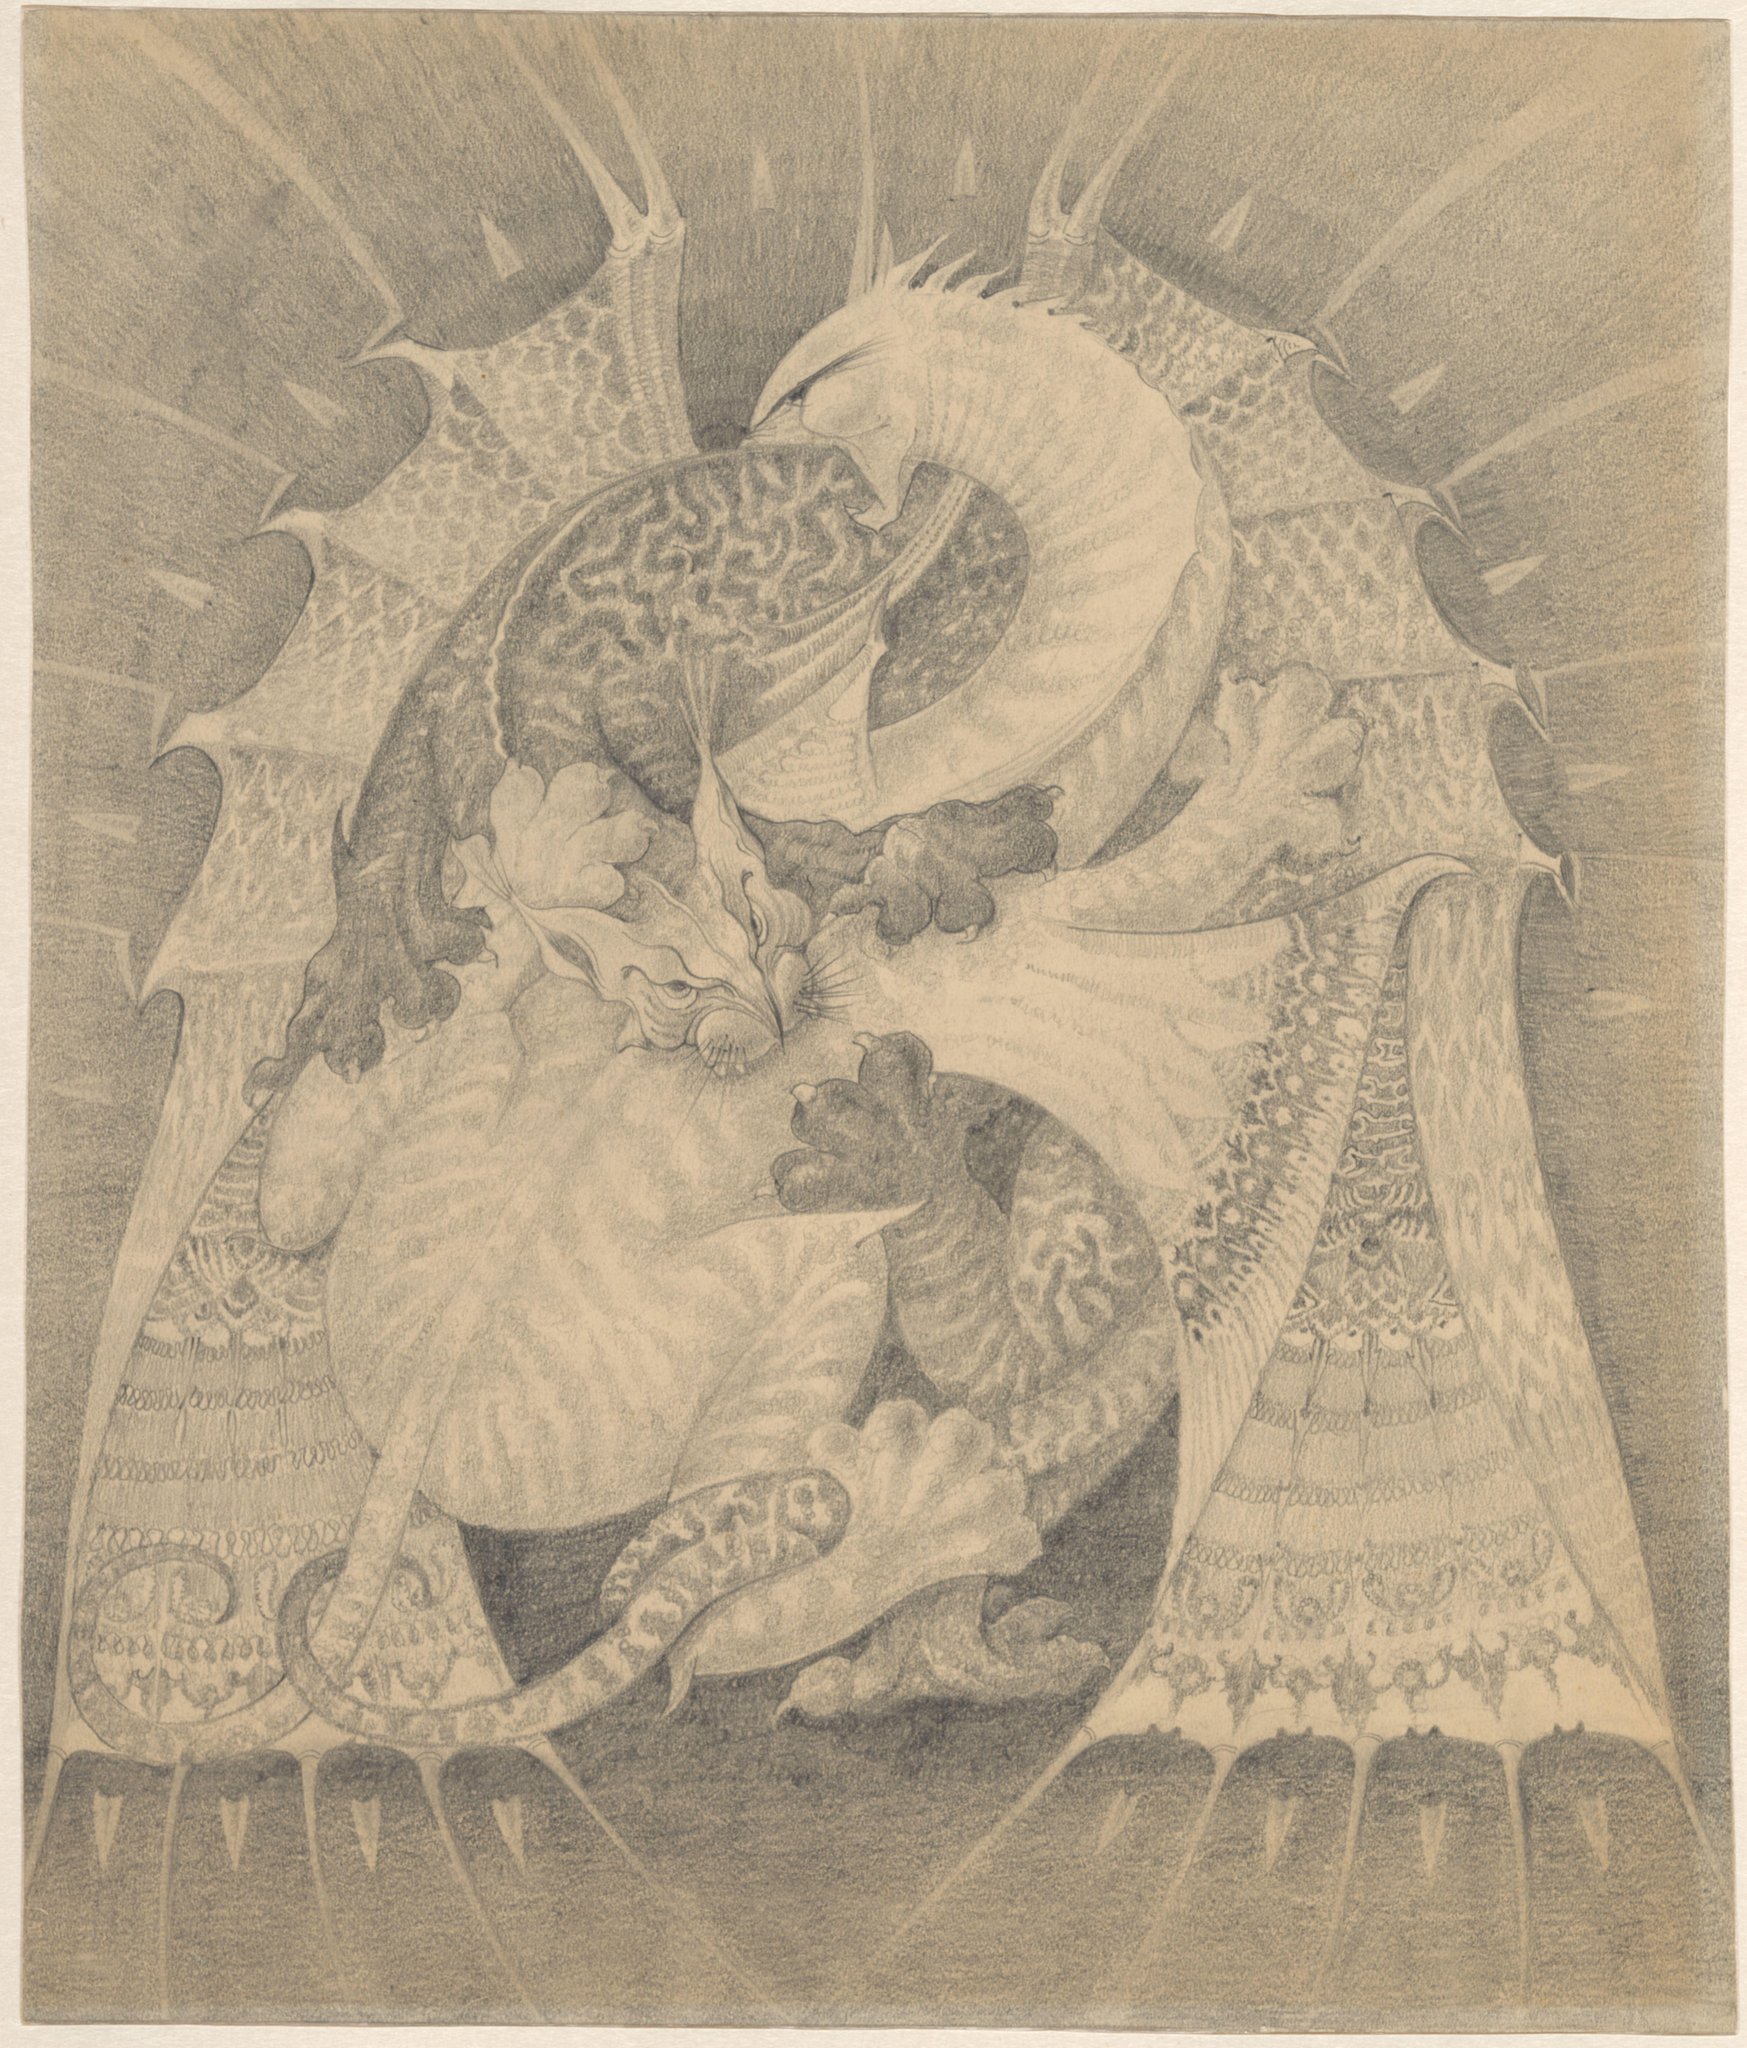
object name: drawing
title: Gevecht tussen twee draken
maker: Anonymous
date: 1910-1940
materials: paper, pencil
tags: dragon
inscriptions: collector's mark: Lugt 2228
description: Twee met elkaar verstrengelde gevleugelde figuren die elkaar bijten.